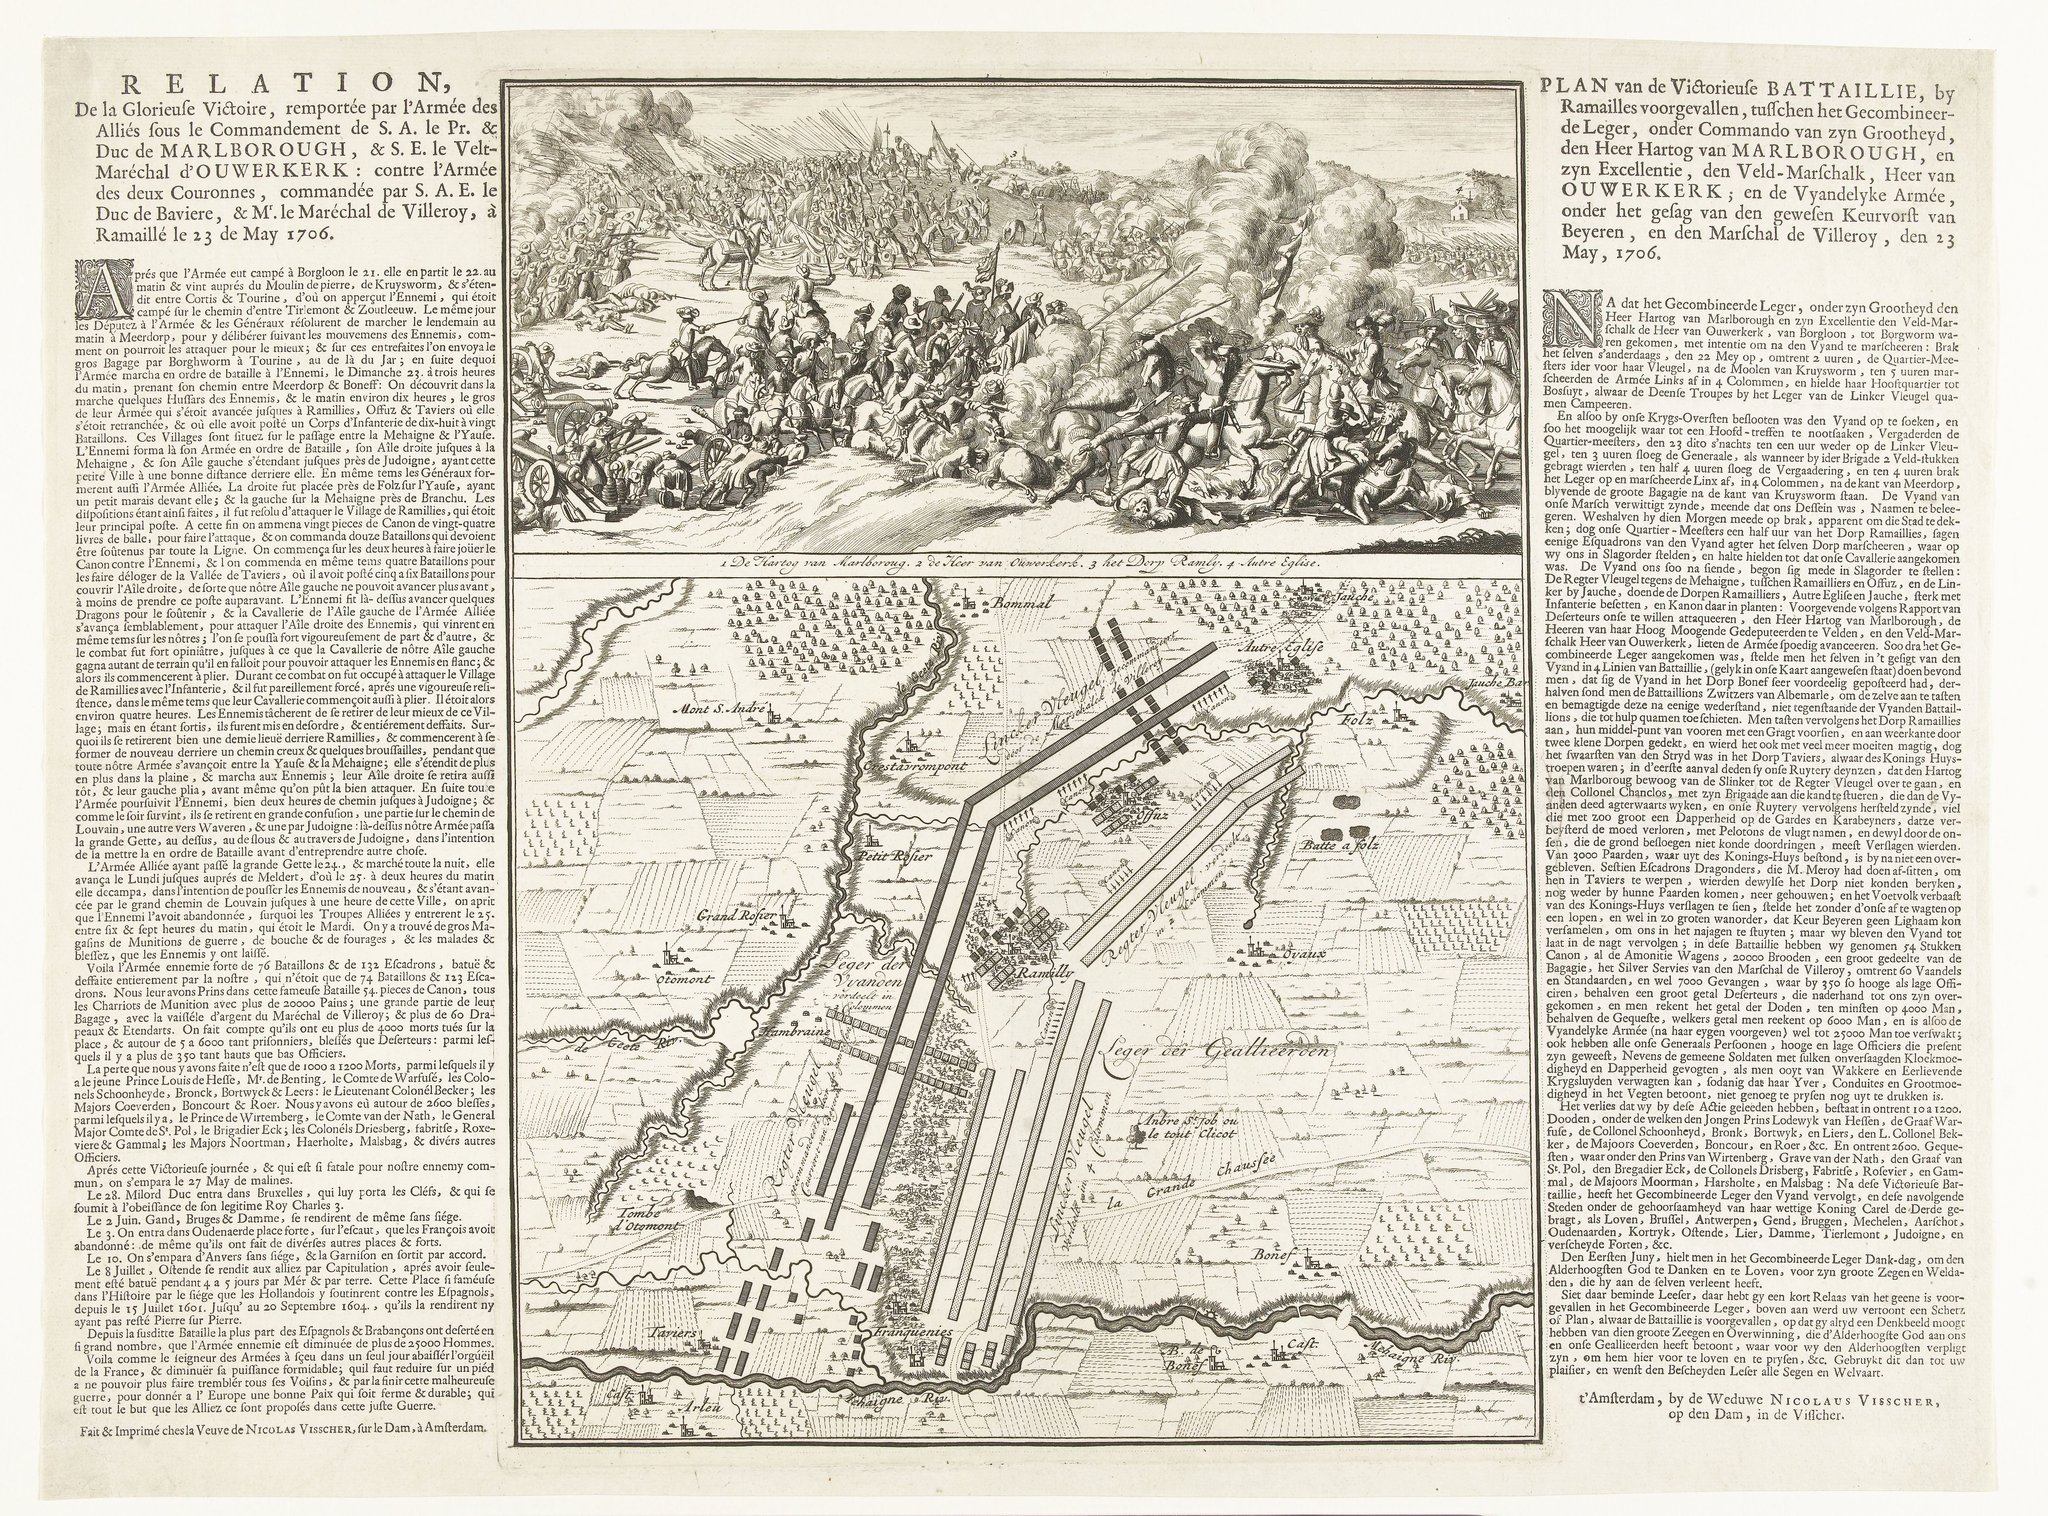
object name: print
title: Relation, De la Glorieuse Victoire, remportée par l'Armée des Alliés sous le Commandement de S.A. le Pr. & Duc de Marlborough, & S.E. le Velt-Maréchal d' Ouwerkerk: contre l'ARmée des deux Couronnes, commandée par S.A.E. le Duc de Baviere, & Mr. le Maréchal de Villeroy, à Ramaillé le 23 de May 1706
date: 1706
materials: paper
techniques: etching, letterpress printing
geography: amsterdam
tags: lyon, paris, françois de neufville (hertog van villeroy), maximiliaan ii emanuel (keurvorst van beieren), john churchill (1e hertog van marlborough), battle (+ land forces)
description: De slag bij Ramillies tussen de Geallieerden onder de hertog van Marlborough en de Heer van Ouwerkerk en de Fransen en Spanjaarden onder de keurvorst van Beieren en de hertog van Villeroy, 23 mei 1706. Centraal een voorstelling en een situatiekaart van de veldslag, aan weerszijden teksten in het Frans en Nederlands.